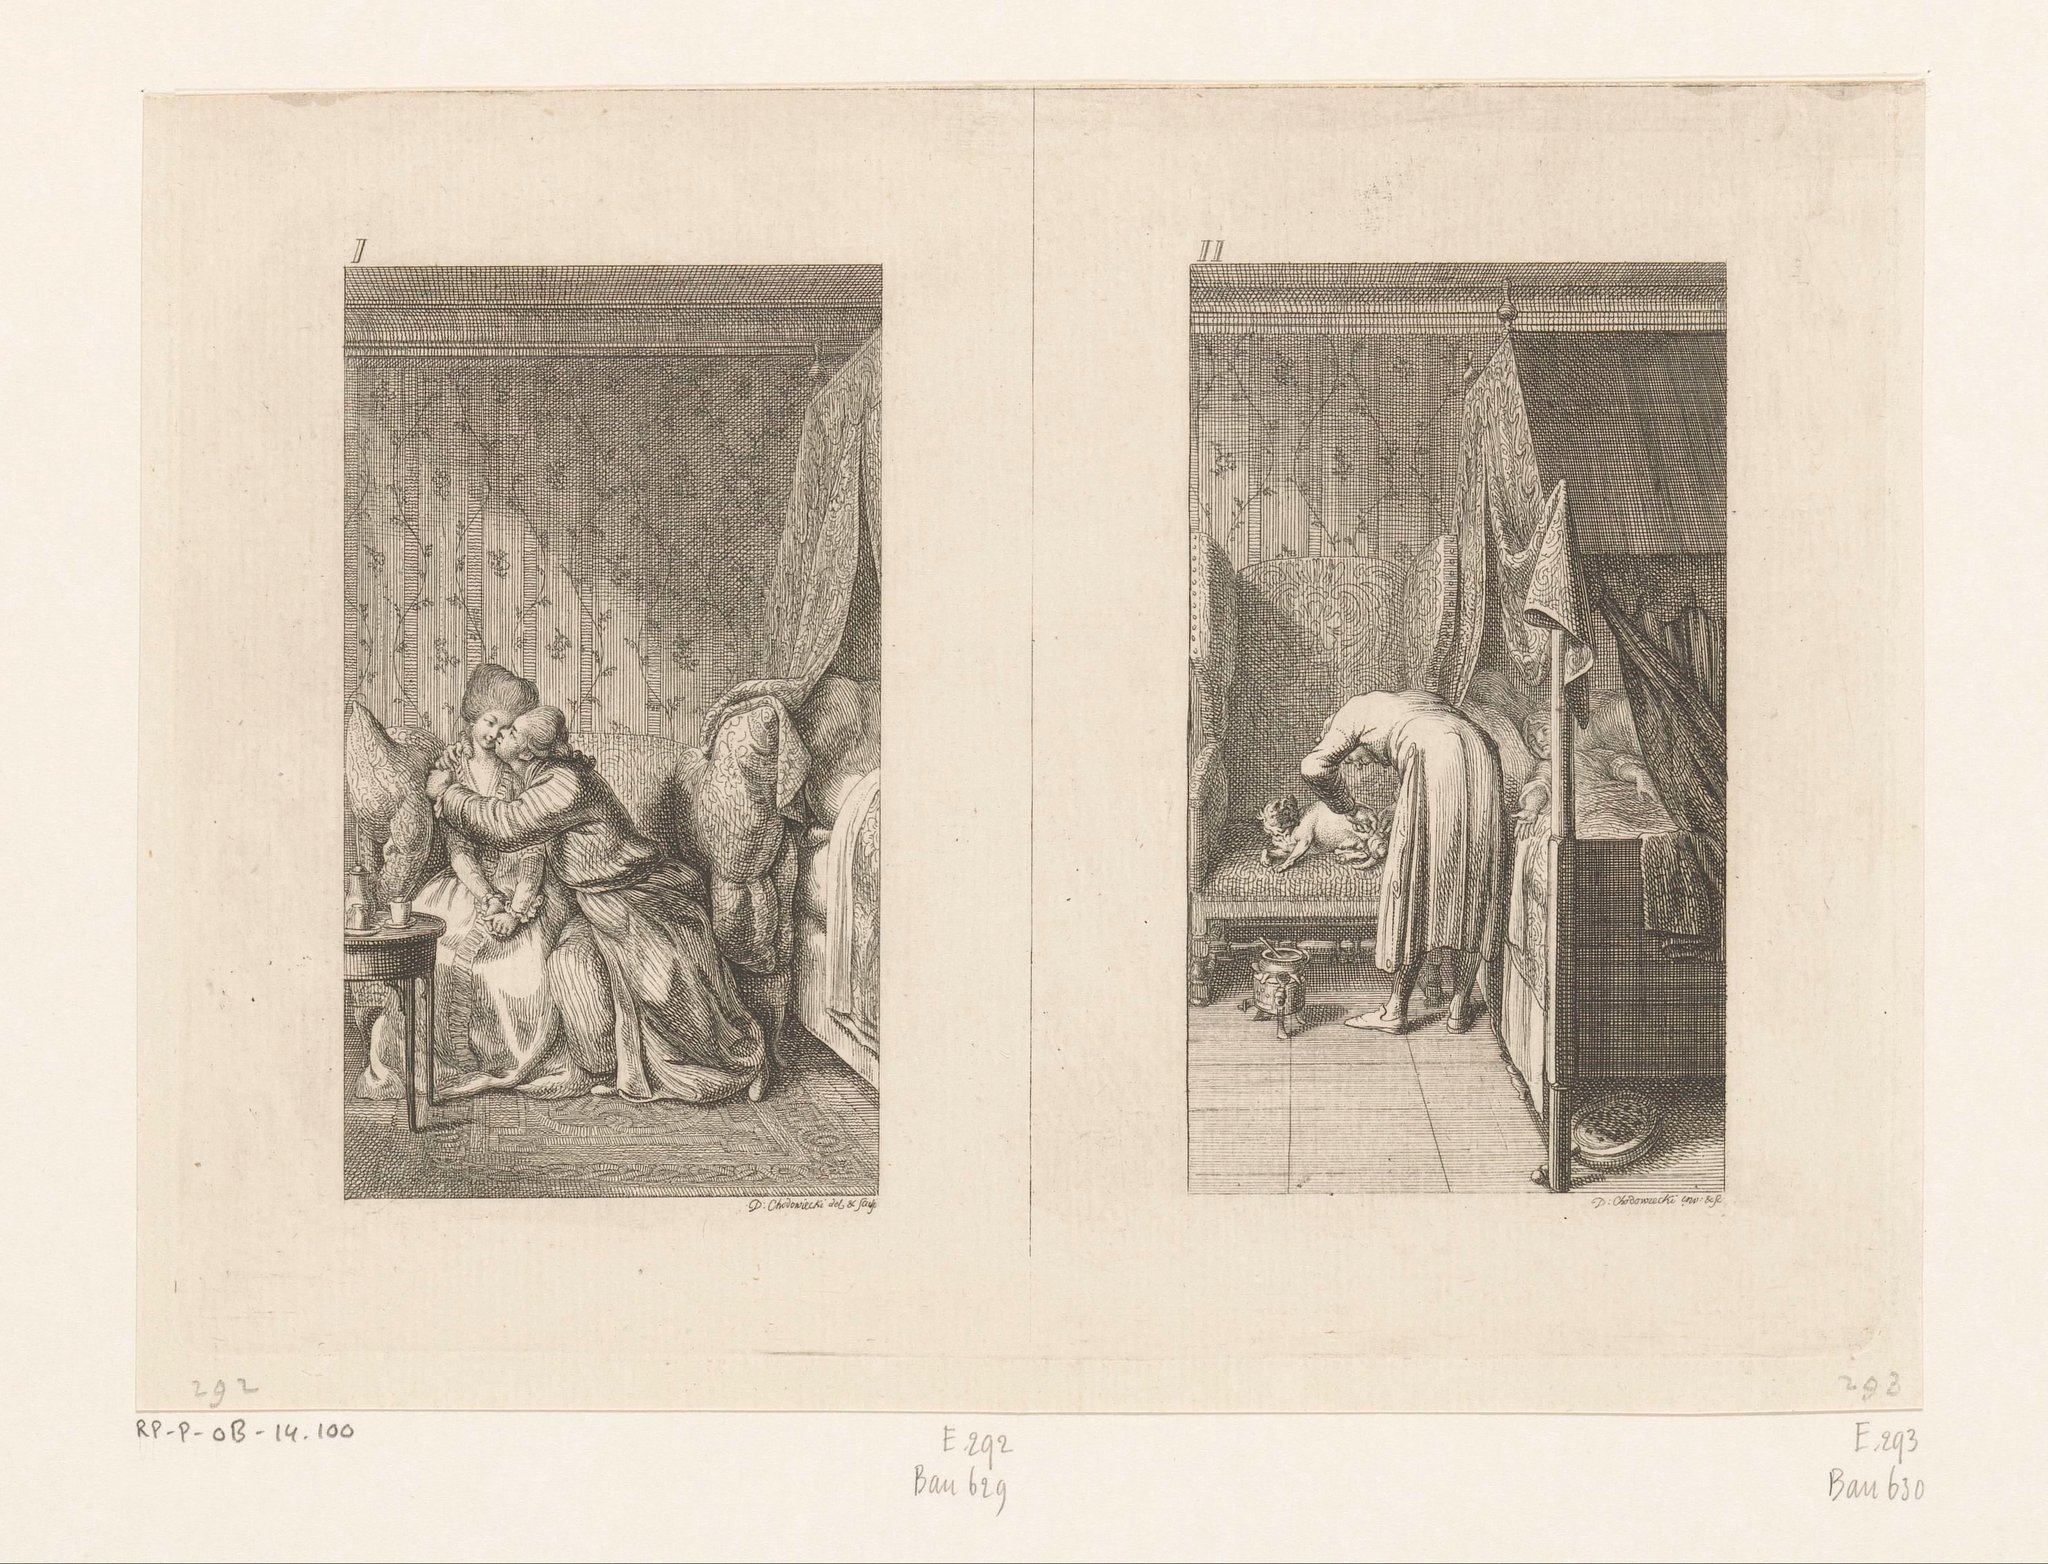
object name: print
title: Peter Marks met zijn eerste en zijn tweede vrouw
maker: daniel nikolaus chodowiecki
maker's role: draughtsman, print maker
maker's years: 1726-1801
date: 1779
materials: paper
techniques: etching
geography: berlin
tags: sick-bed, (lovers) kissing each other, dog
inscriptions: collector's mark: Lugt 2228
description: Eerste en tweede prent uit een serie van zes voorstellingen die de geschiedenis van Peter Marks illustreren. Deze prentserie is ook gebruikt in: Wezel, Johann Karl. Peter Marks. Eine Ehestandgeschichte. Leipzig: Dykischen Buchhandlung, 1779.